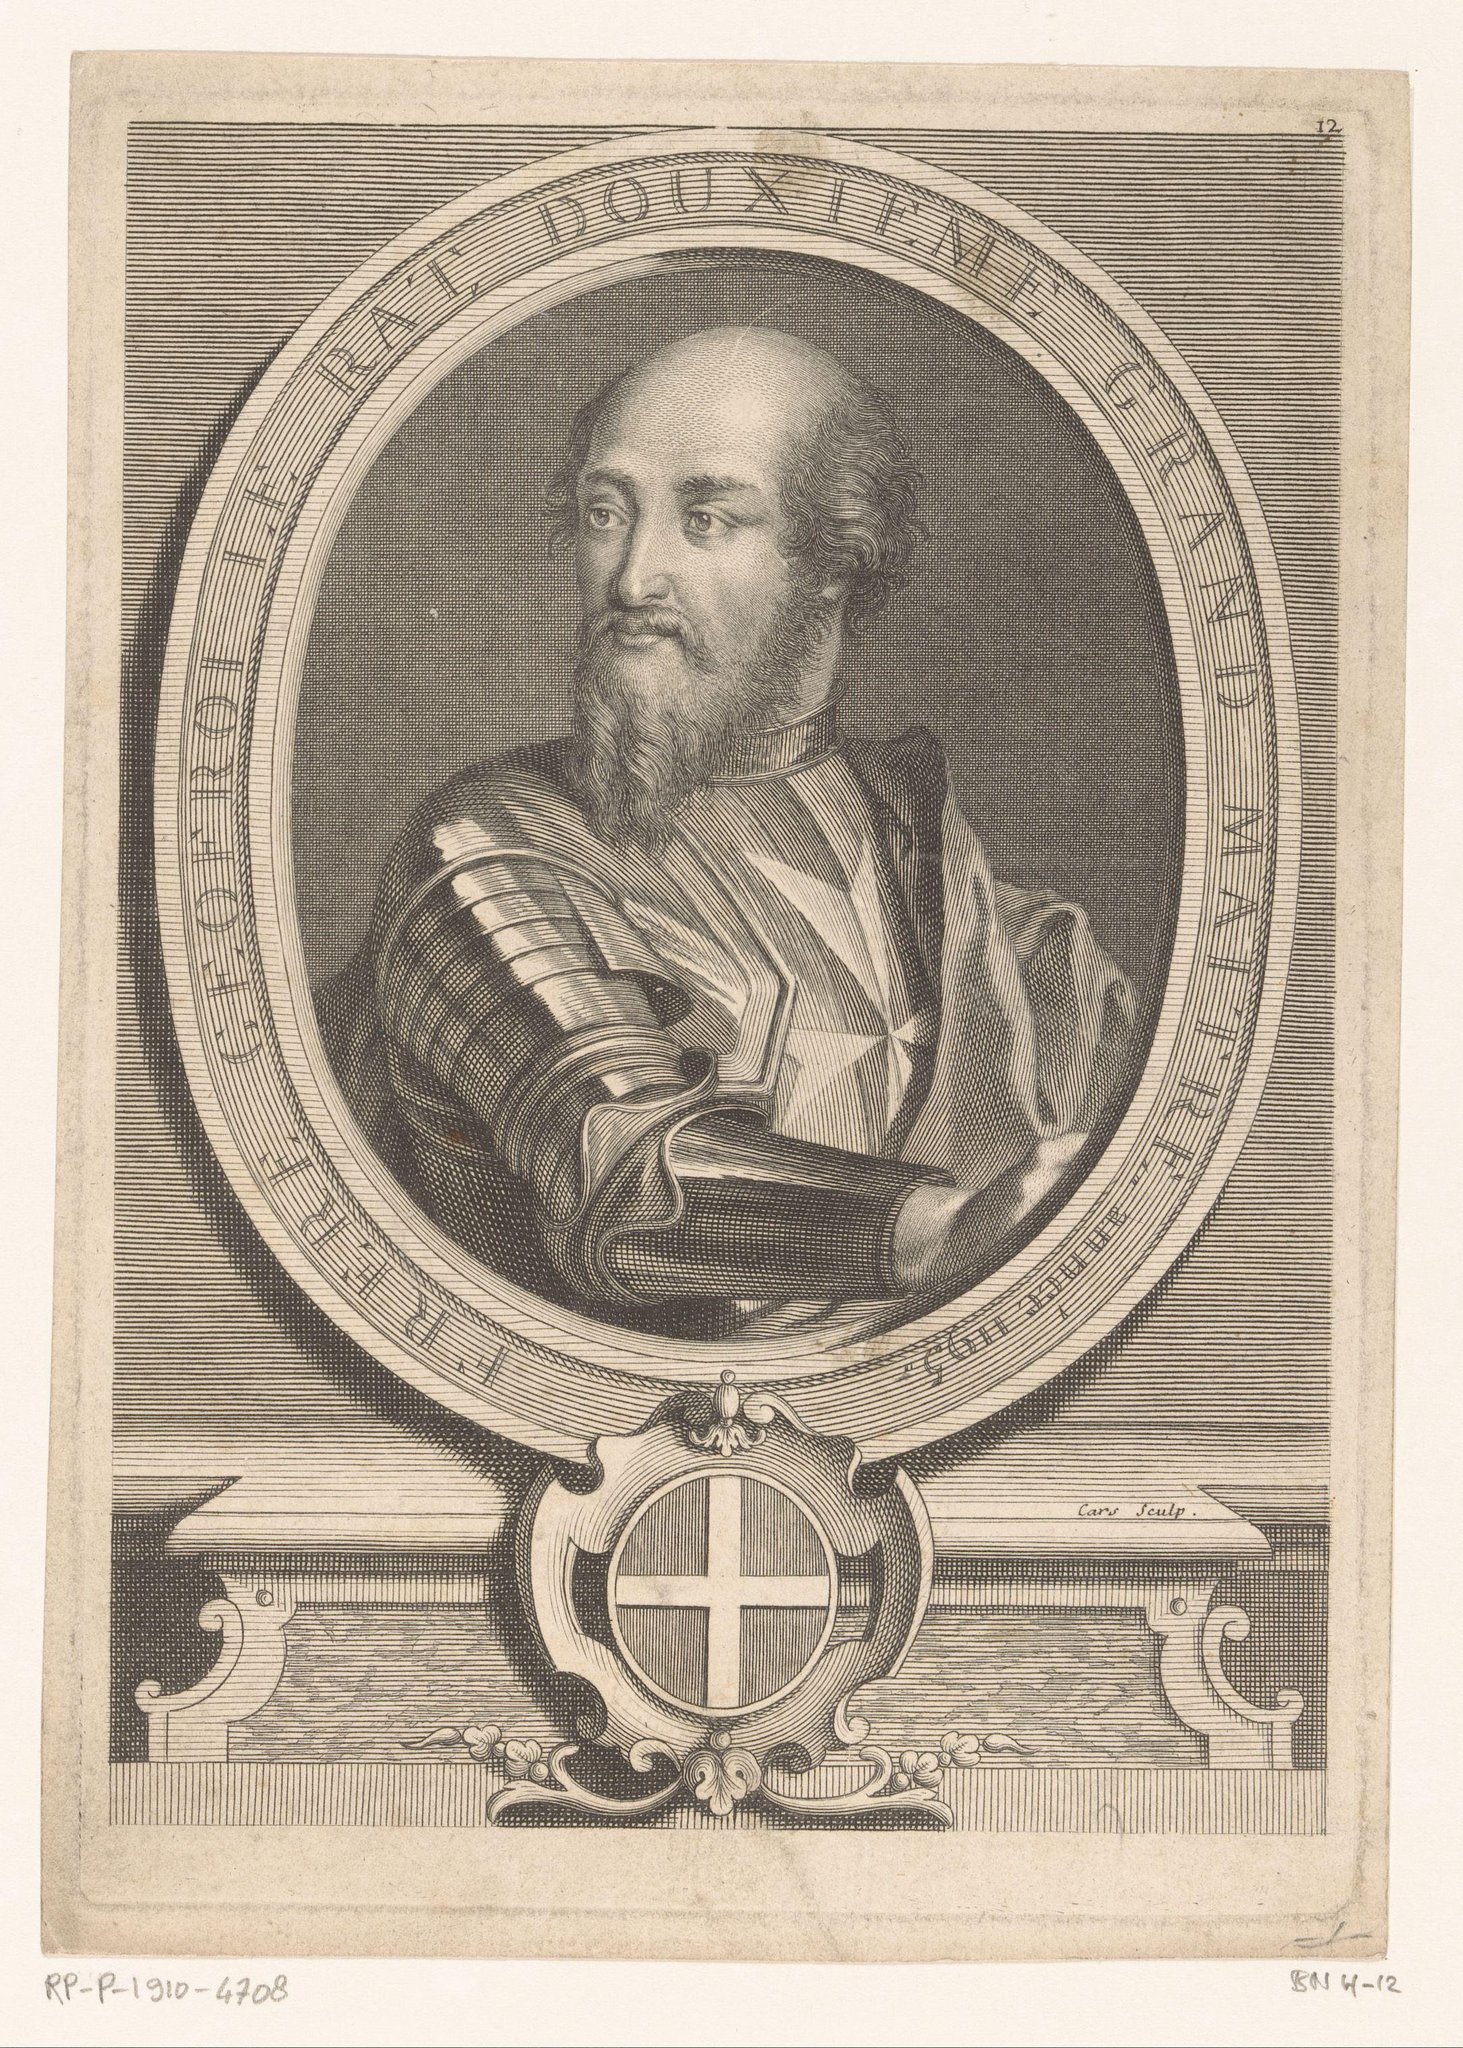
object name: book illustration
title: Portret van Geoffroy le Rat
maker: laurent cars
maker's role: print maker, publisher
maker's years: 1699-1771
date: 1726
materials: paper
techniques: engraving, etching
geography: france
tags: historical persons, military orders, e.g.: knights templars, knights of malta, teutonic knights ~ roman catholic church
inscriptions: collector's mark: Lugt 2228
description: Prent uit: Vertot, René Aubert de. Histoire des Chevaliers hospitaliers de St Jean de Jérusalem. Parijs: Rollin, Quillau, Desaint, 1726. Illustratie op p. 258 van deel 1. Cars vervaardigde portretten van 65 grootmeesters van de Maltezer Orde.